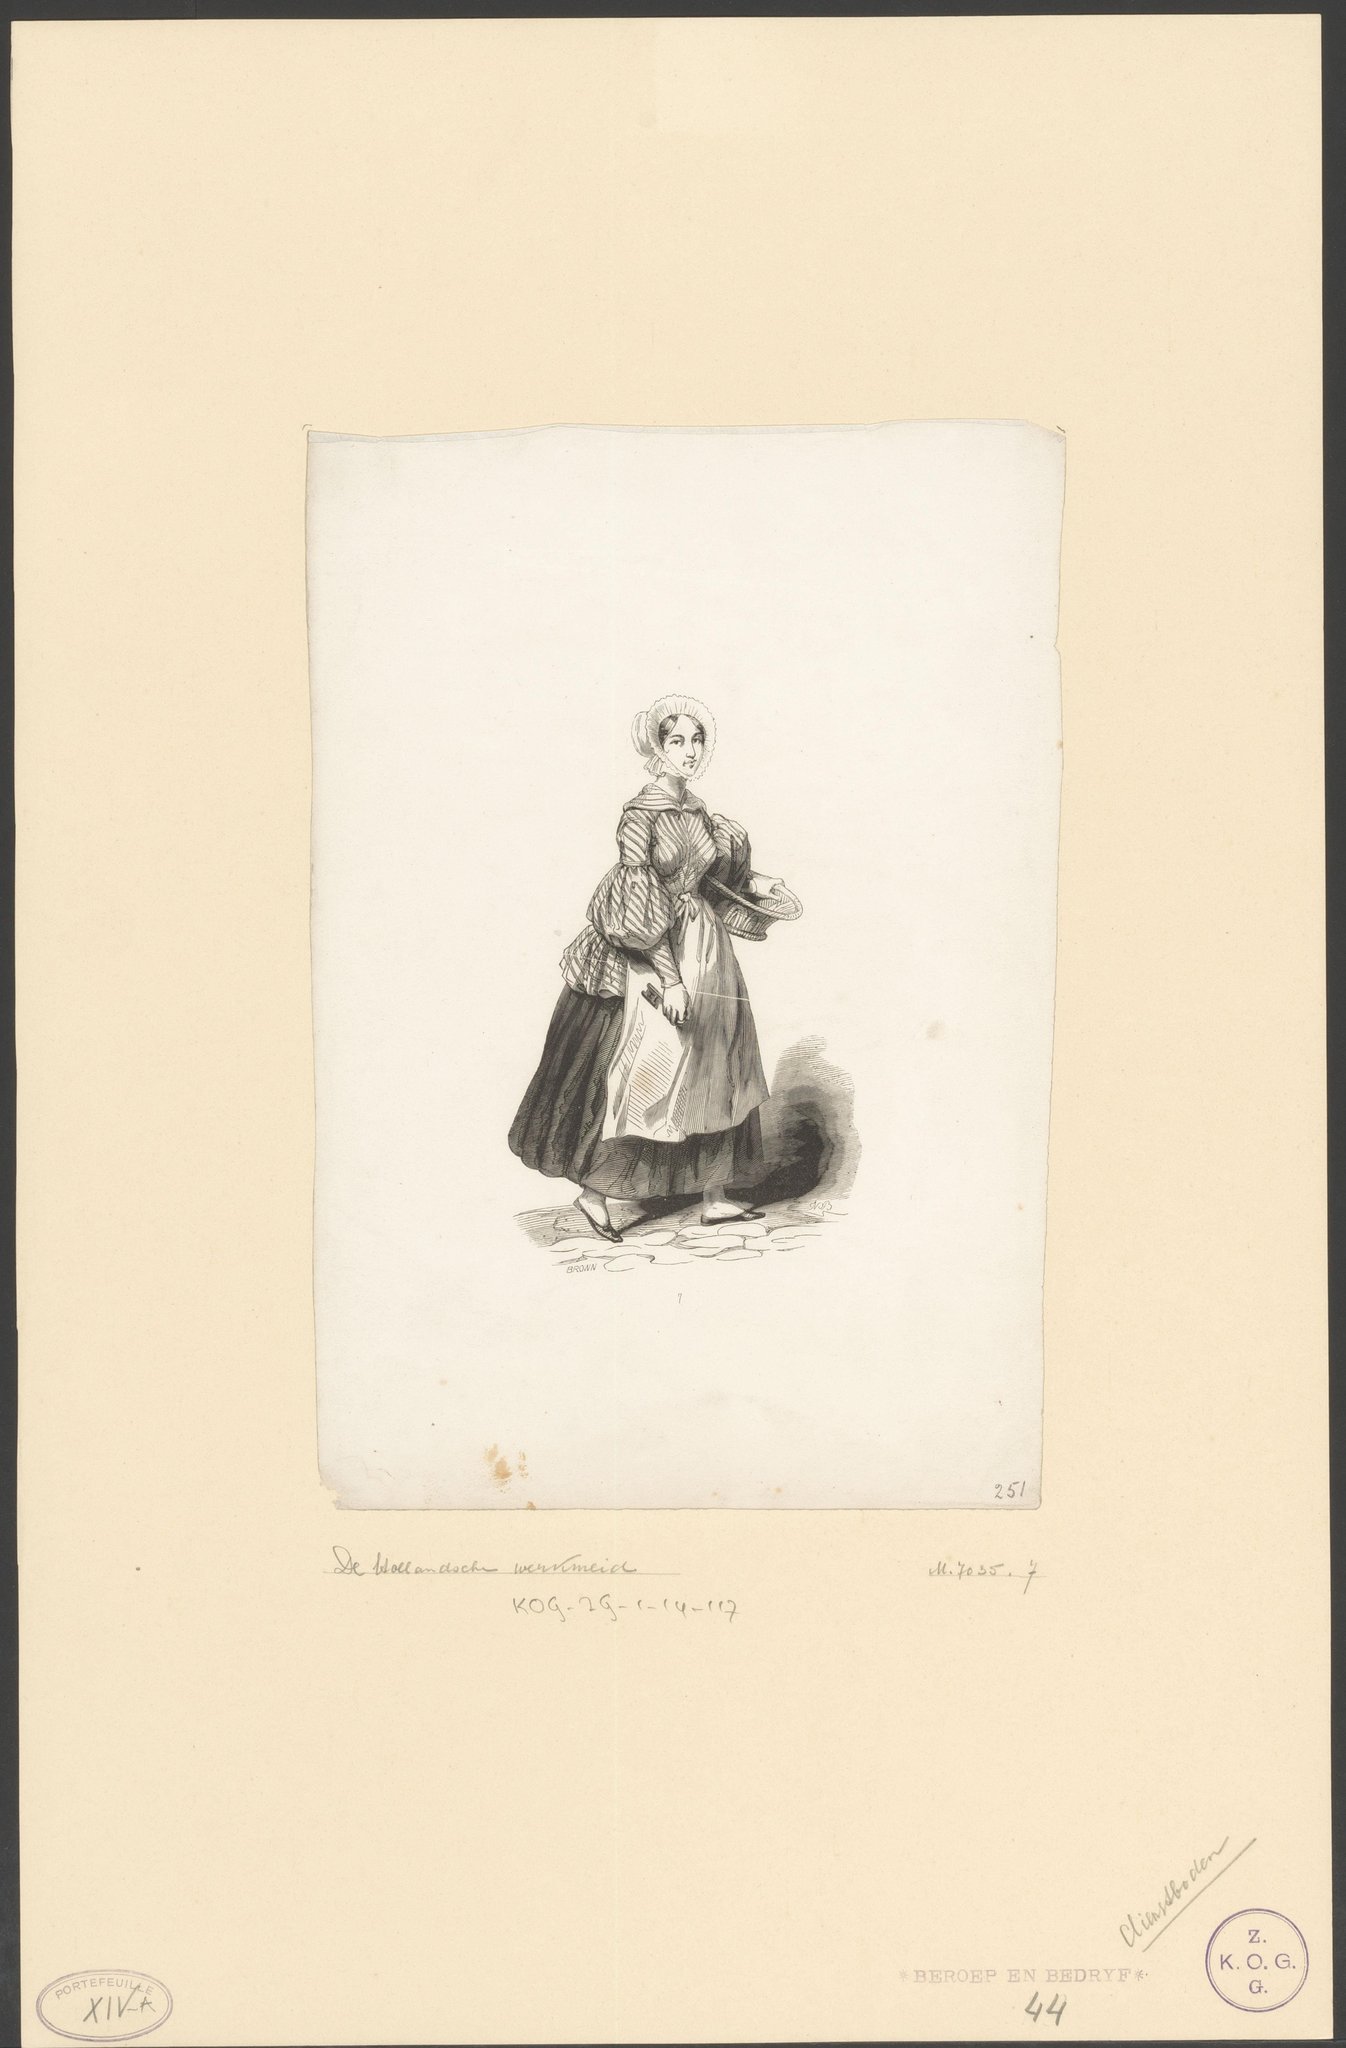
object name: print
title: De Hollandsche werkmeid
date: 1841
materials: paper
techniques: engraving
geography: netherlands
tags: professional clothes, maid ~ house personnel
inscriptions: collector's mark, collector's mark: Lugt 1641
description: De Hollandse werkmeid, dienstbode. Staande jonge vrouw met mand onder de arm. Genummerd: 7. Illustratie in het boek 'De Nederlanden: karakterschetsen, kleederdrachten, houding en voorkomen van verschillende standen', een boek met karakterschetsen, beroepen en klederdrachten van Nederlandse volkstypen uit 1841. Onderwerpsrubrieken binnen de Atlas Zeden en Gewoonten: Beroep en bedrijf. Vrouwelijk beroep en bedrijf. Dienstboden.